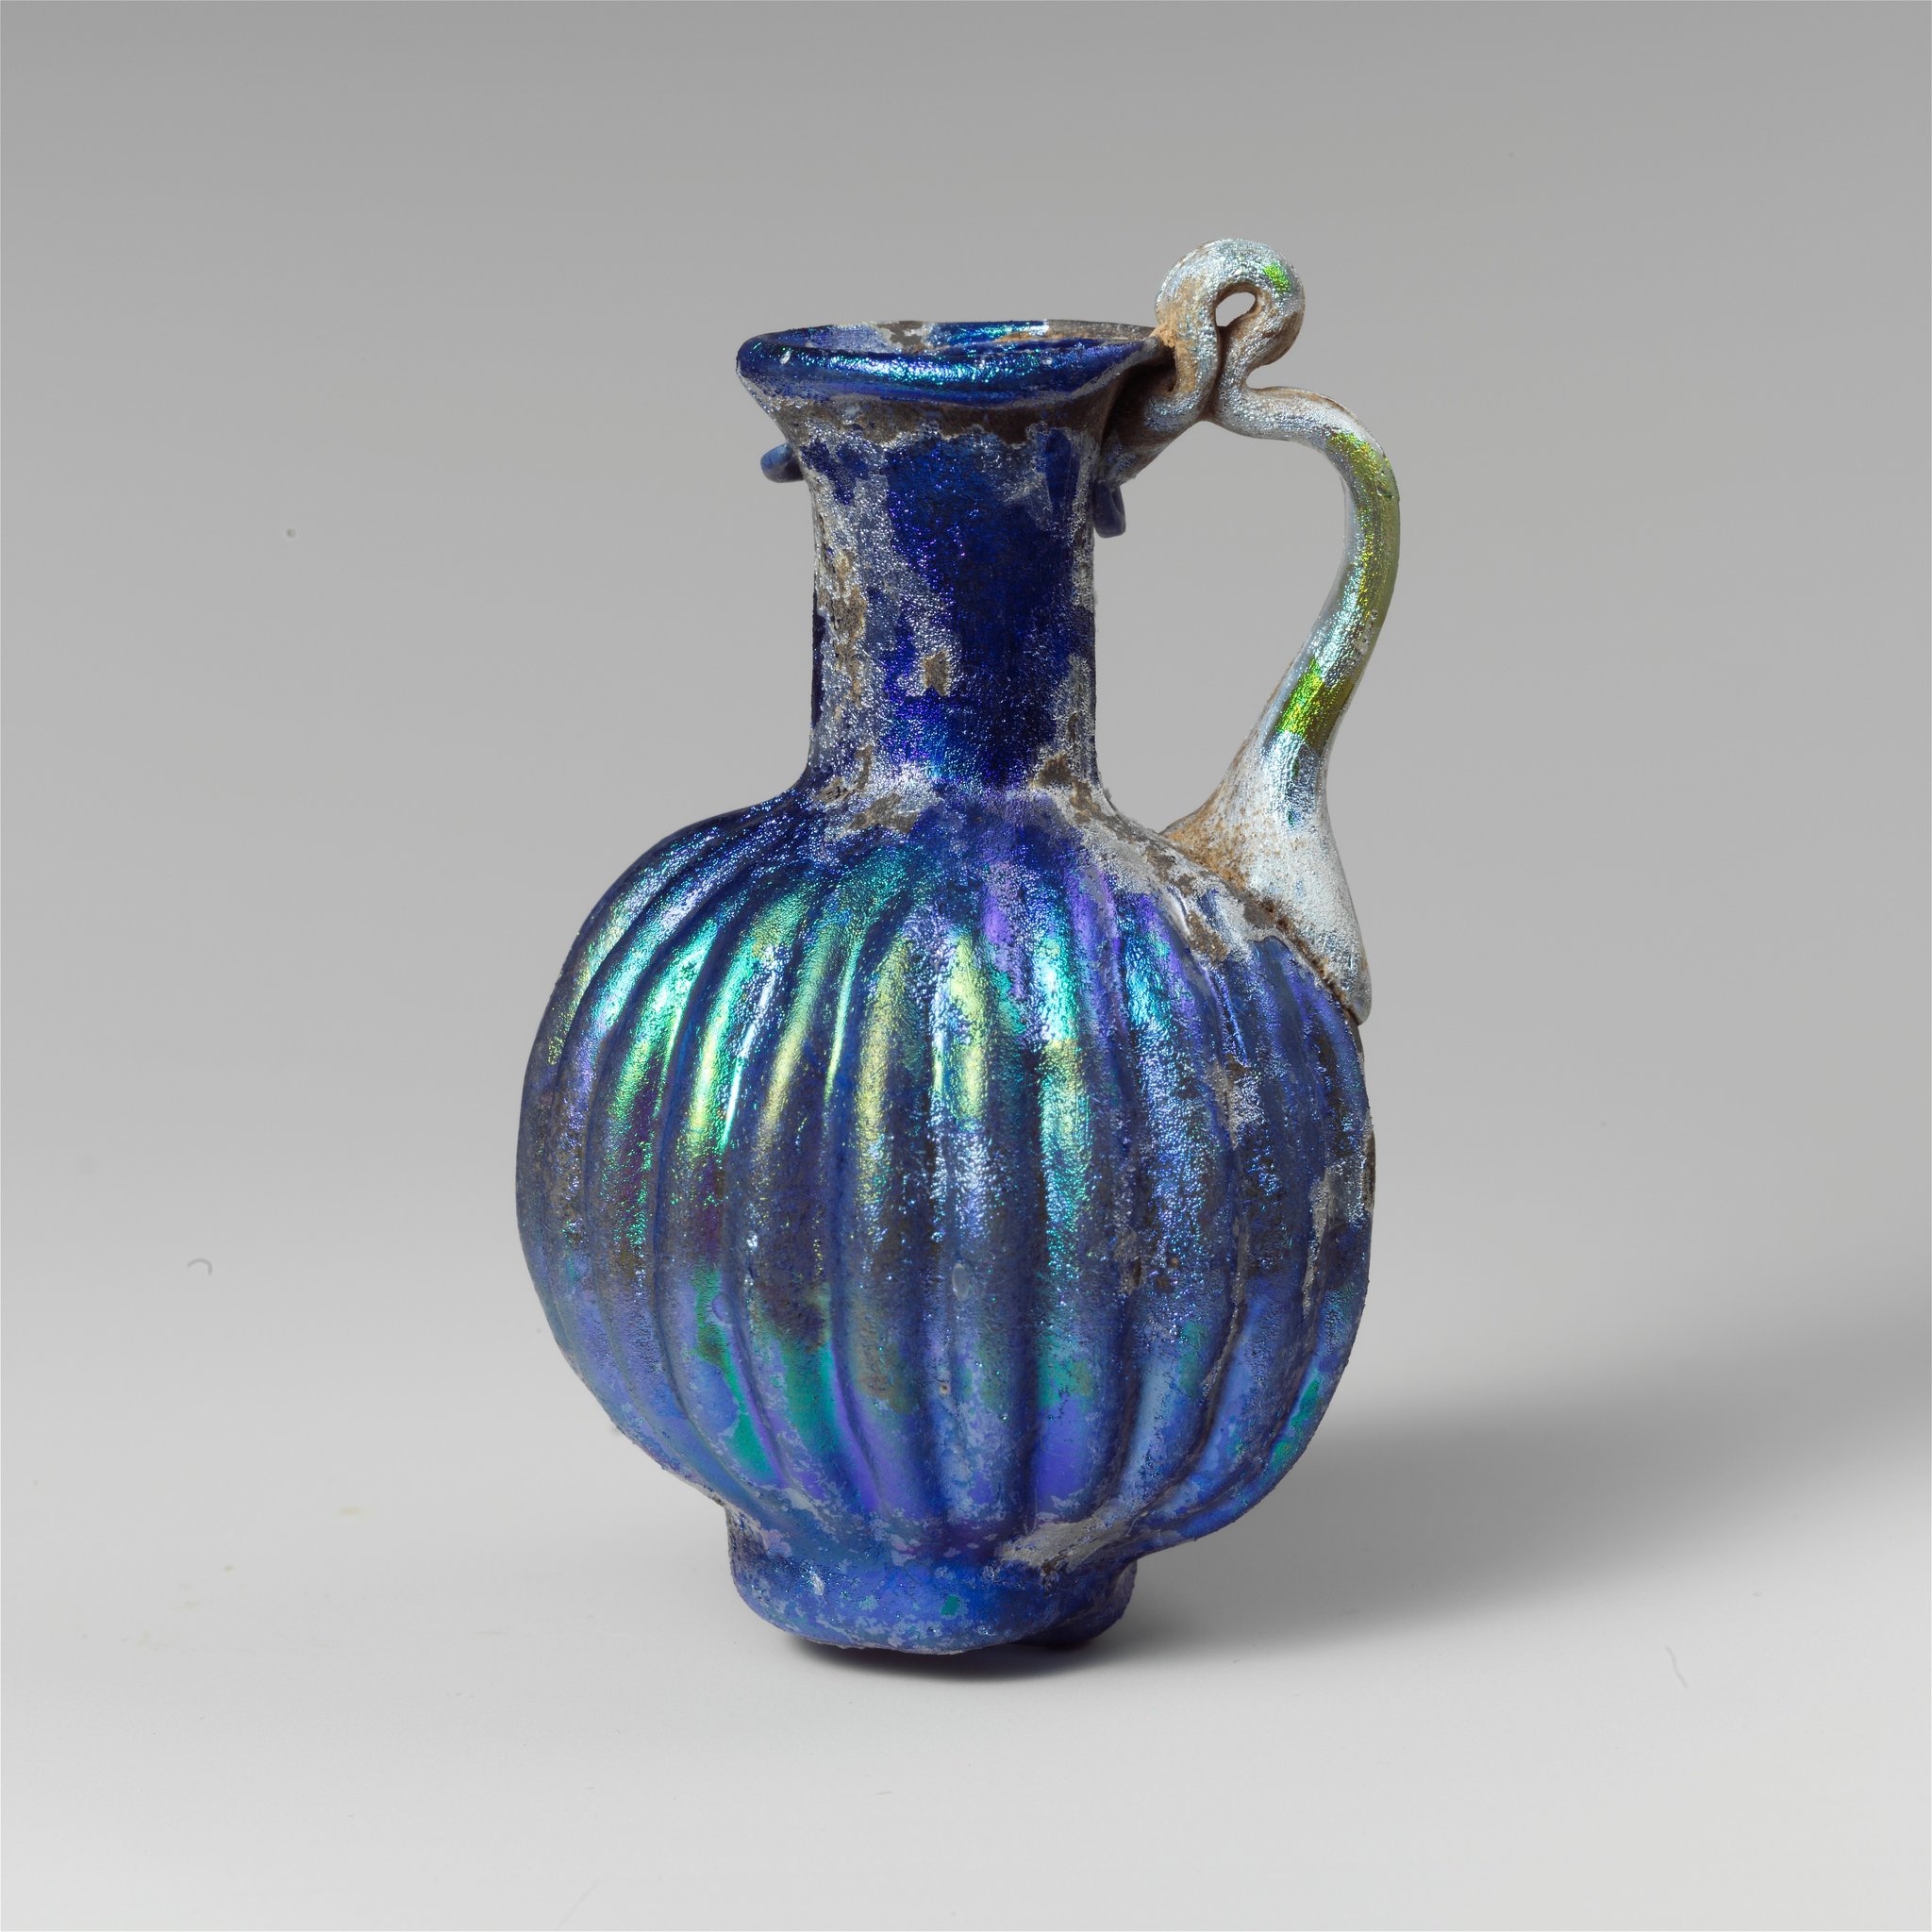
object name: juglet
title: Glass juglet with vertical ribbing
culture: roman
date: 51-100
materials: glass